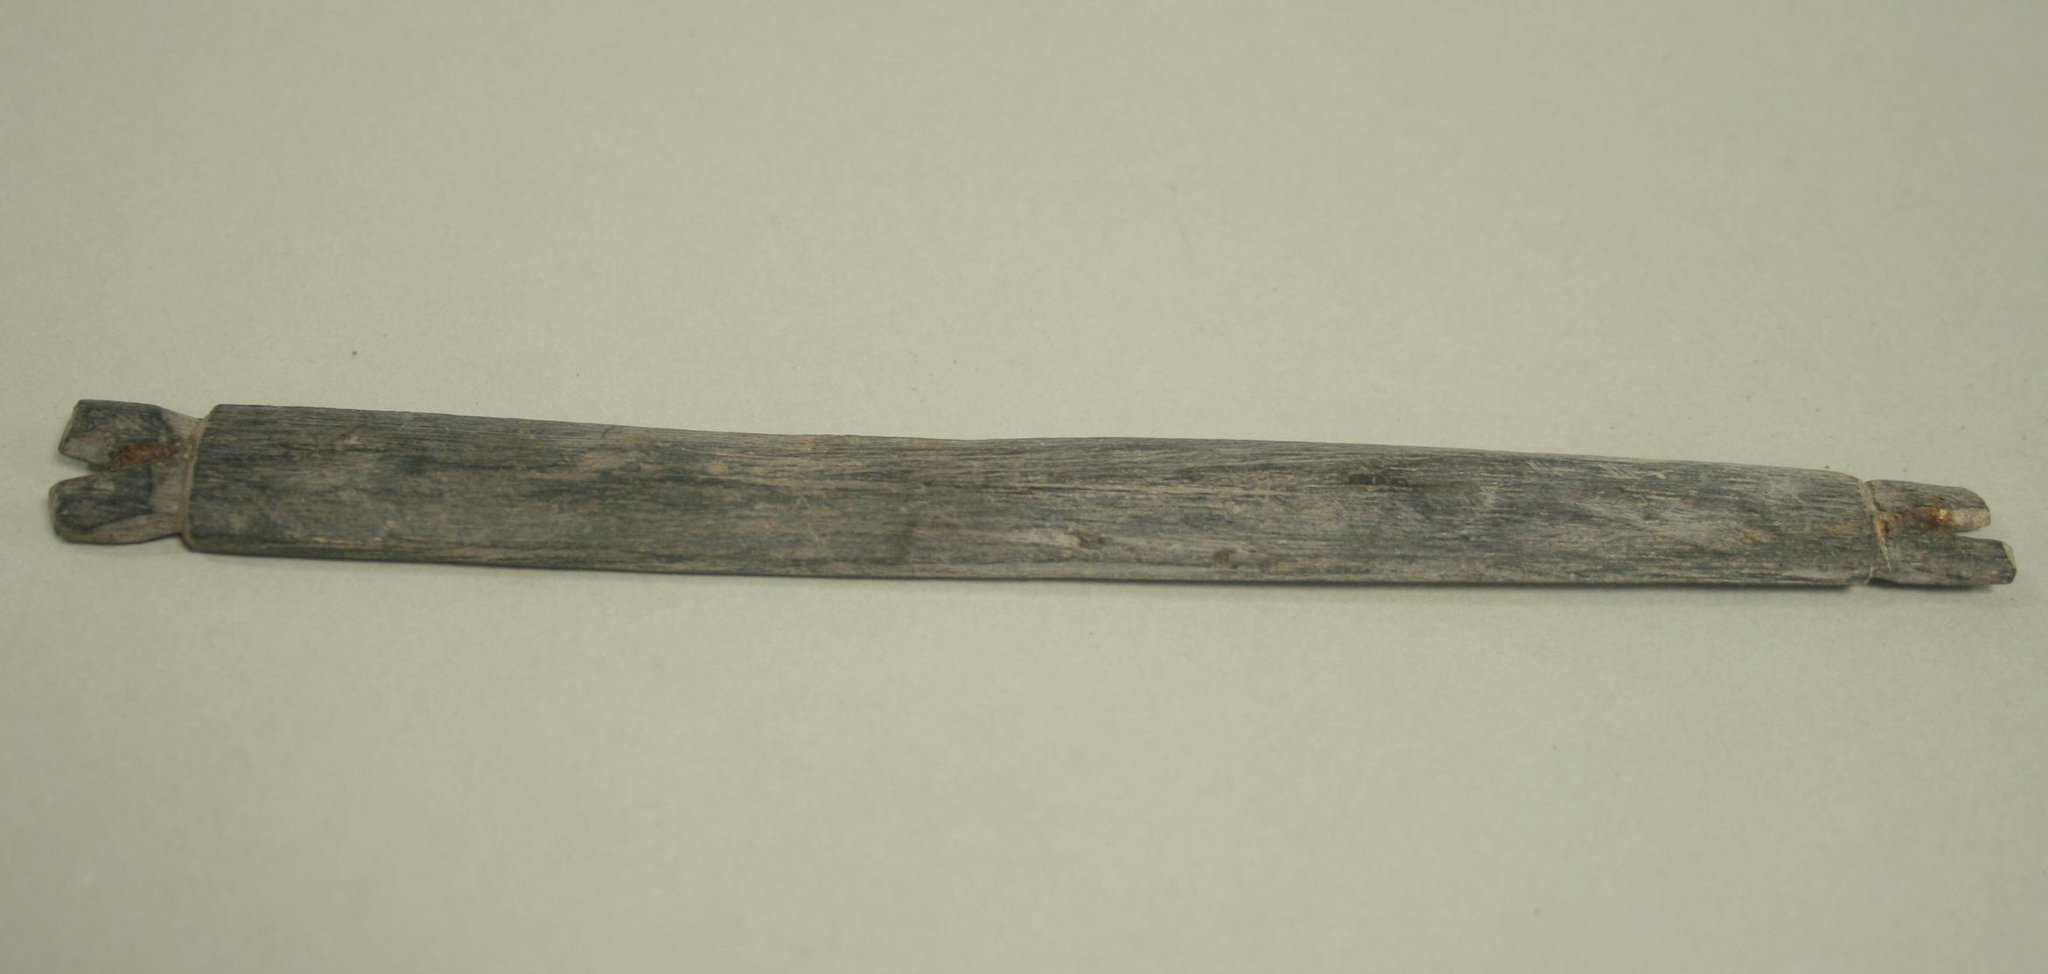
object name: loom bar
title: Wooden Loom Bar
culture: peruvian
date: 1501-1600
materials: wood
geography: peru